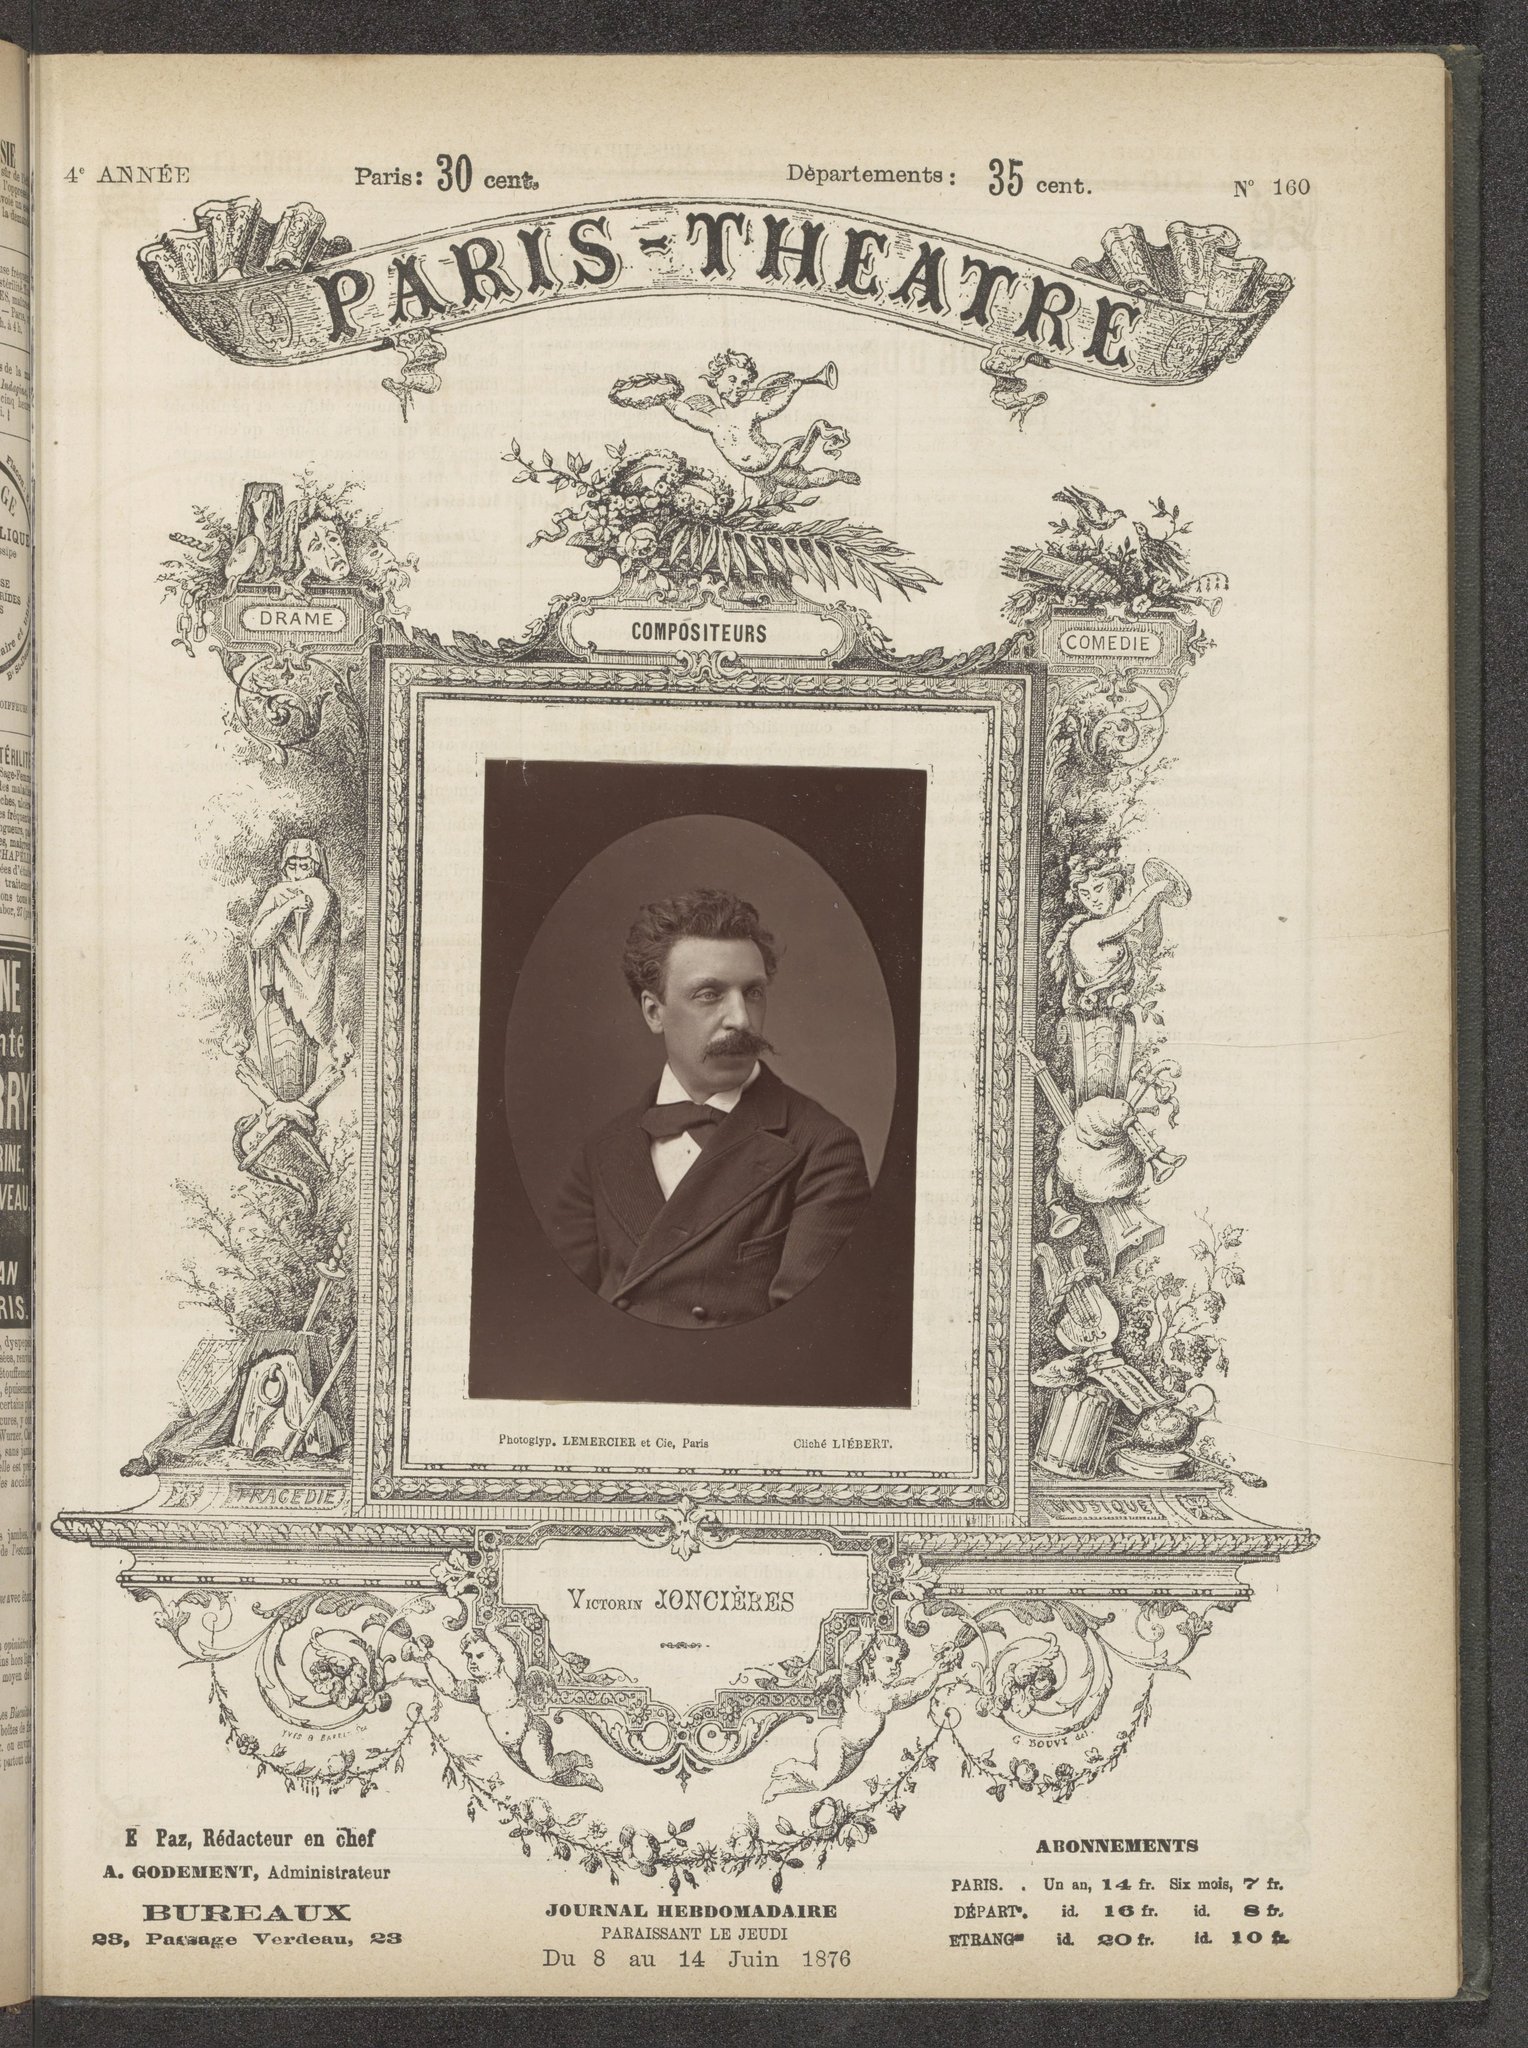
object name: page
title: Portret van Victorin de Joncières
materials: paper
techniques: woodburytype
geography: france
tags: composer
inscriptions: number: ‘No 160’, inscription: ‘Journal hebdomadaire paraissant le jeudi Du 8 au 14 Juin 1876’